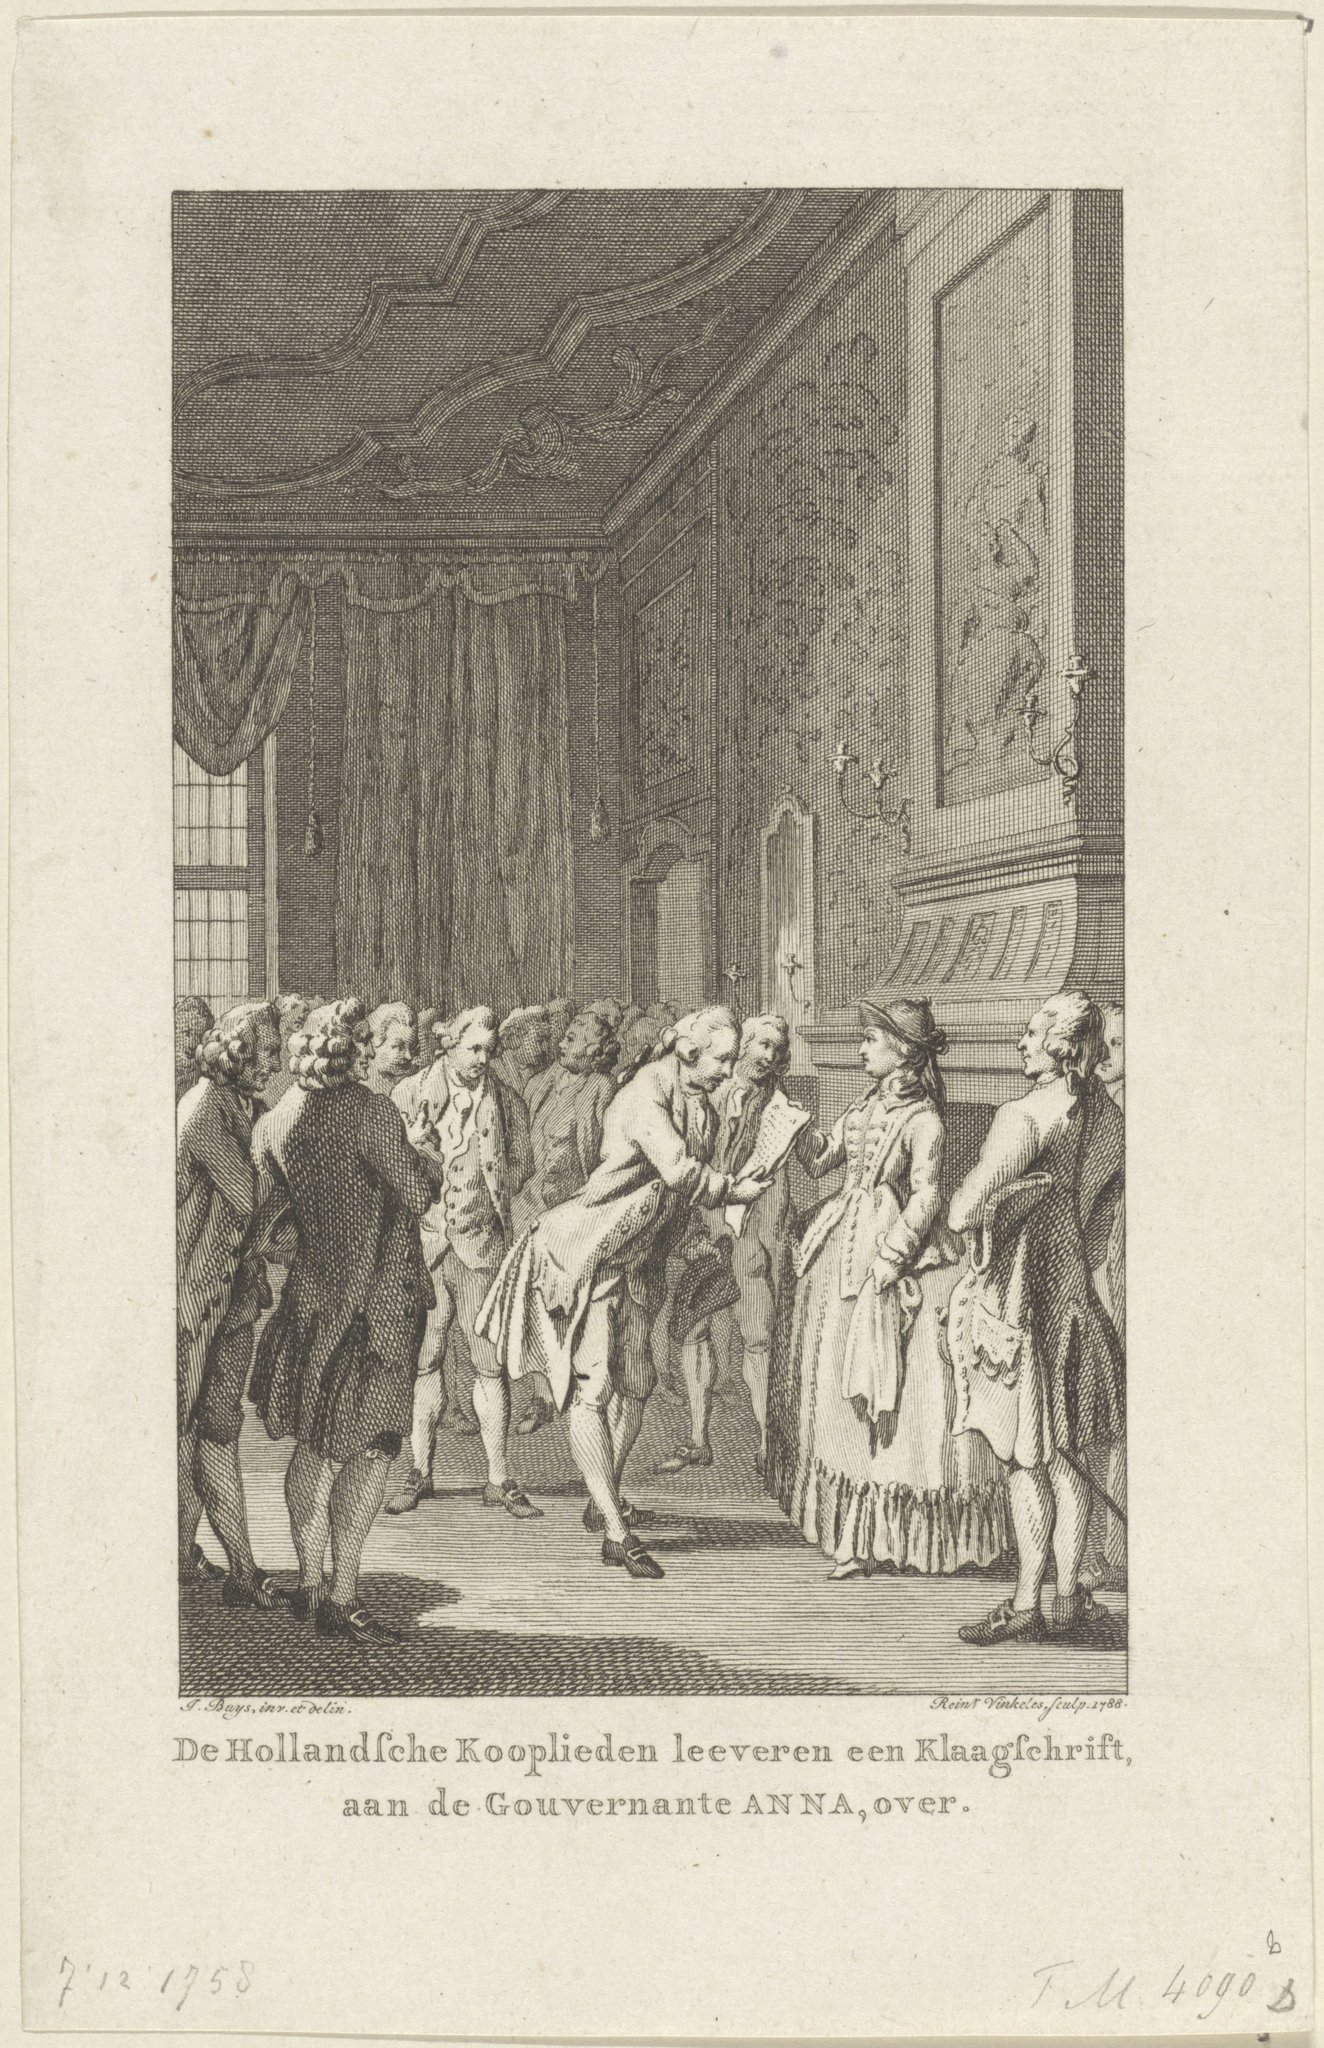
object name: print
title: Hollandse kooplieden overhandigen prinses Anna een klaagschrift over de Engelse aanvallen, 1758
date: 1788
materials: paper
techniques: engraving, etching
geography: amsterdam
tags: the hague, anna van hannover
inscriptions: date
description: Een delegatie van Hollandse kooplieden overhandigt aan de gouvernante (prinses Anna van Hannover) een klaagschrift over de Engelse aanvallen, 7 december 1758. Waarschijnlijk naar aanleiding van overvallen door de Engelsen op Nederlandse schepen in de Antillen.